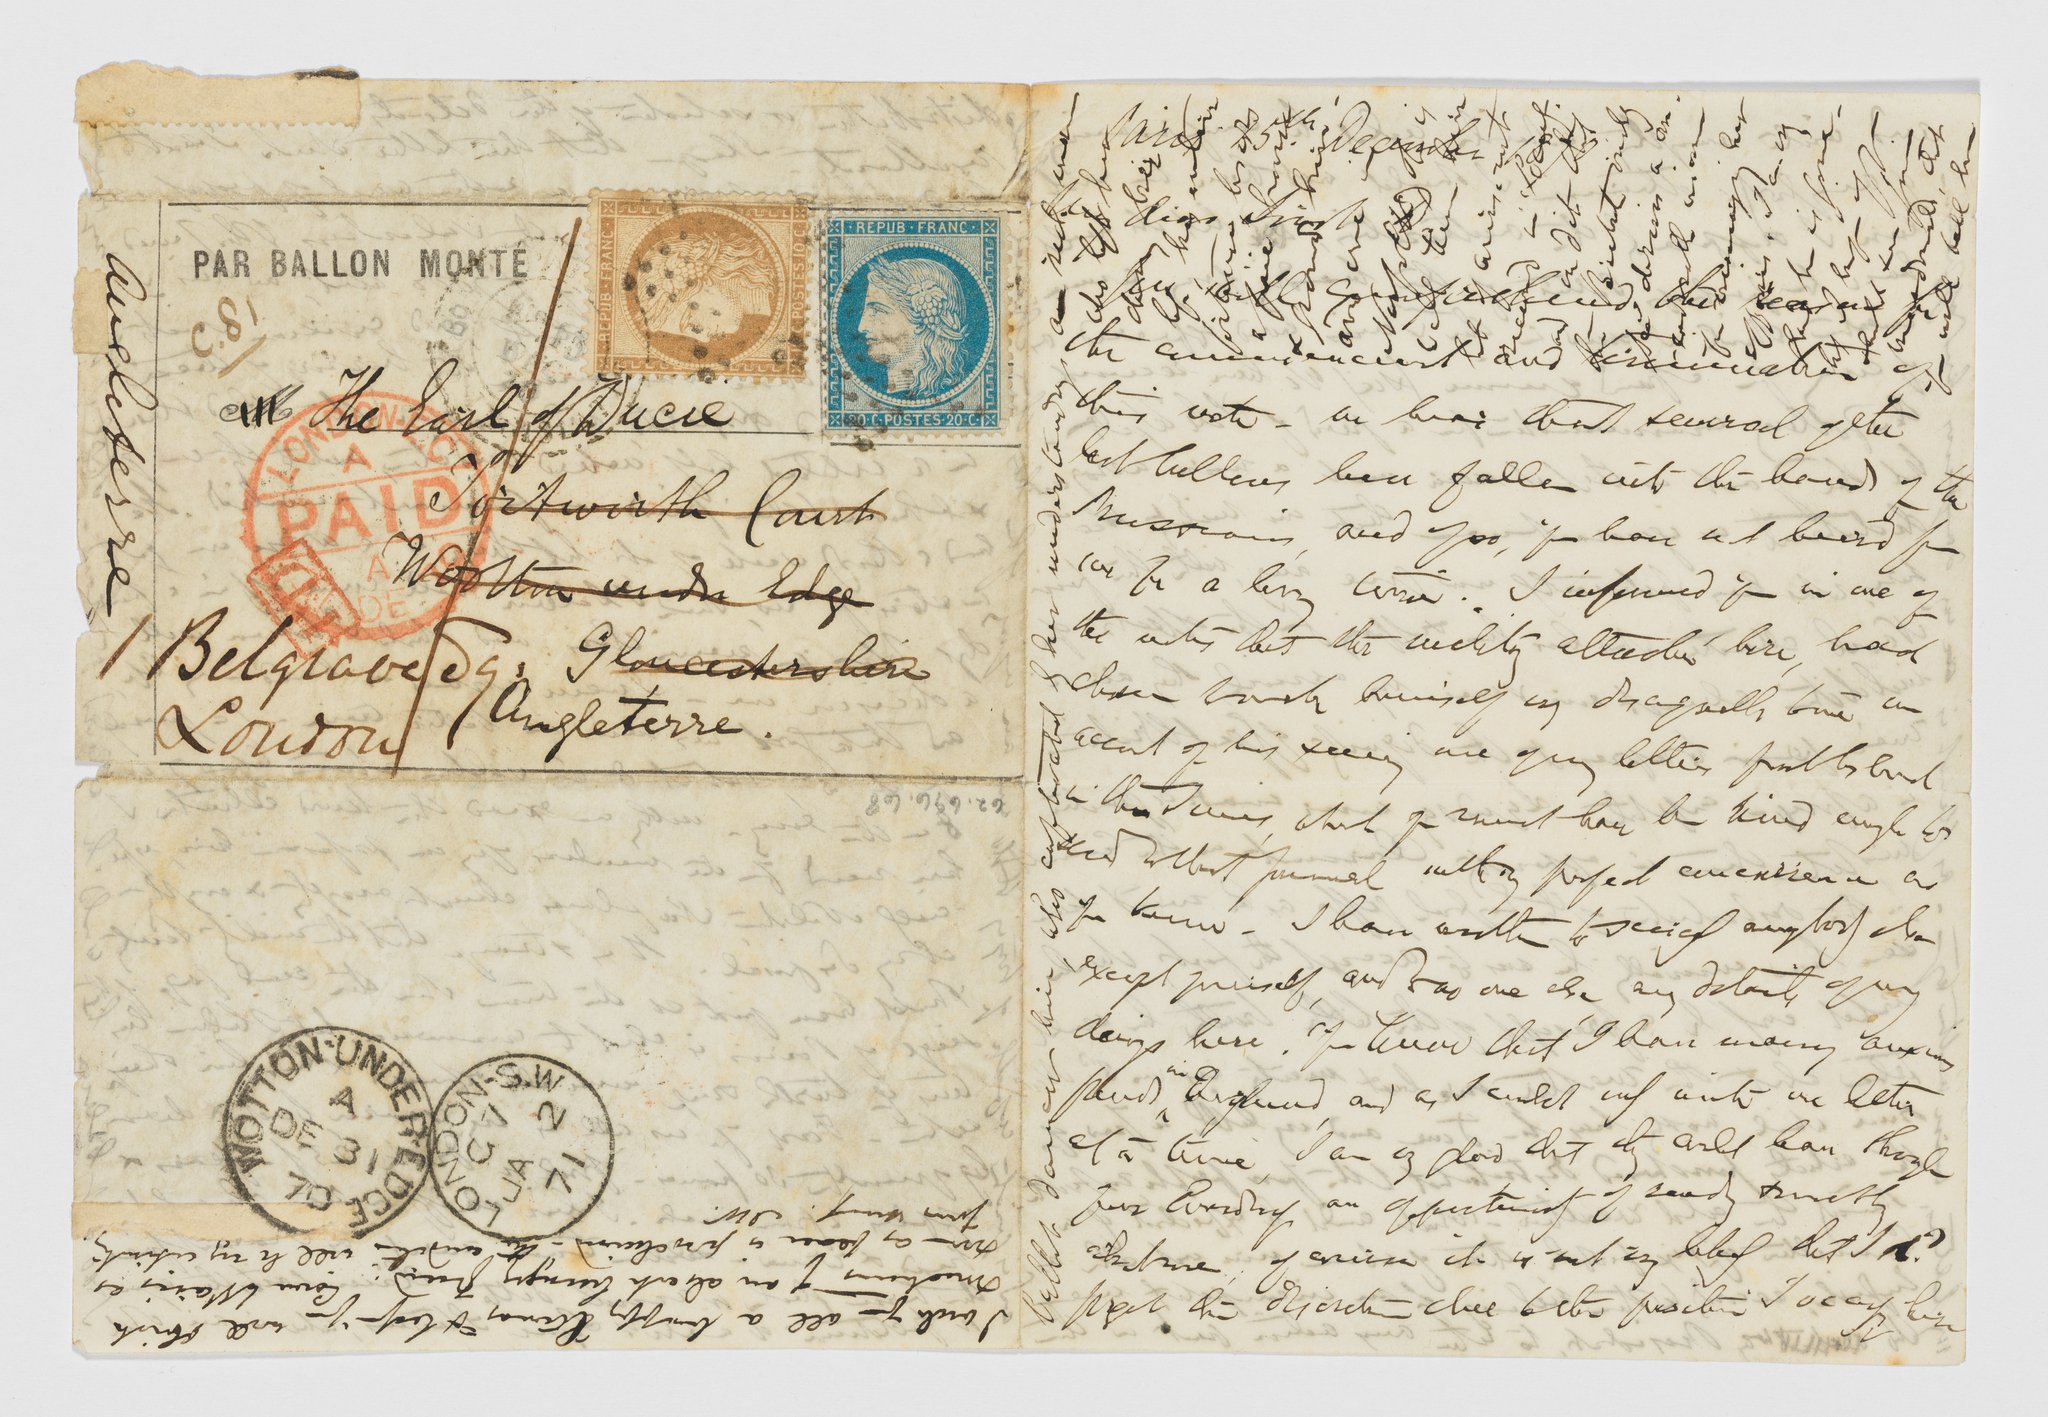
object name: ephemera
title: Letter sent "Par Ballon Monte" to the Earl of Ducie, from "I.W."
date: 1870